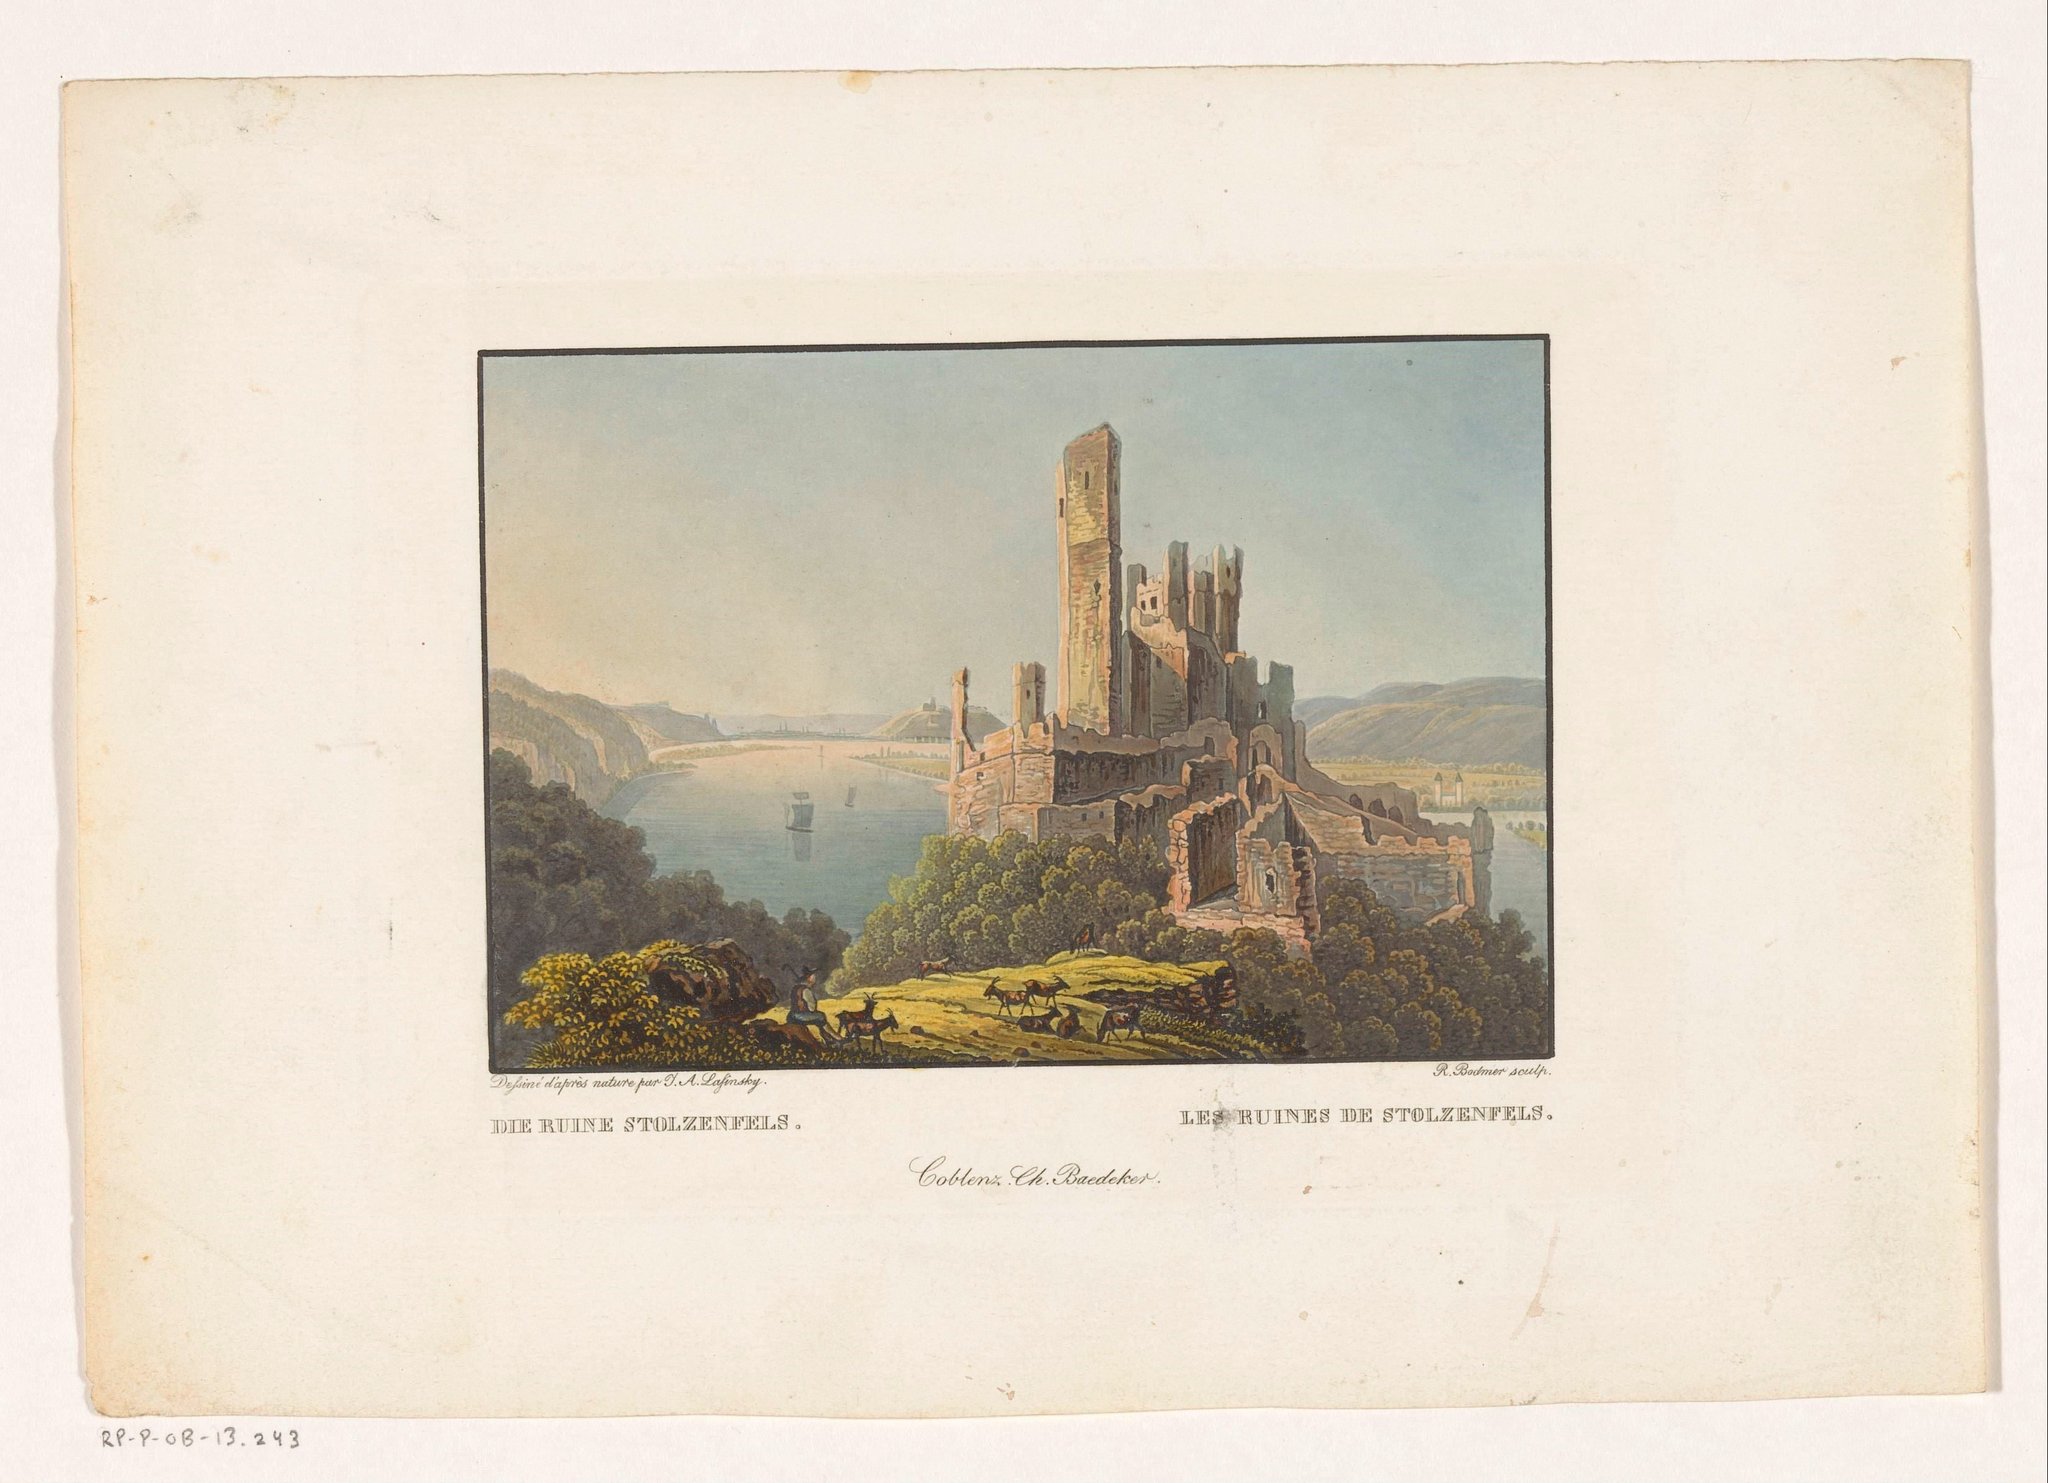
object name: print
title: Die Ruine Stolzenfels / Les ruines de Stolzenfels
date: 1832-1872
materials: paper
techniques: hand coloring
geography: zurich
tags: river, ruin of a dwelling, house, castle, etc.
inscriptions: collector's mark: Lugt 2228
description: Vanaf 1828 verschenen bij Franz Friedrich Röhling in Koblenz verschillende uitgaven met prenten van burchten en kastelen gelegen langs de Rijn, vervaardigd door Rudolf Bodmer naar tekeningen van Adolf Lasinsky. Vanaf 1832 verschenen deze publicaties bij Karl Baedeker, die het fonds van Röhling had overgenomen.